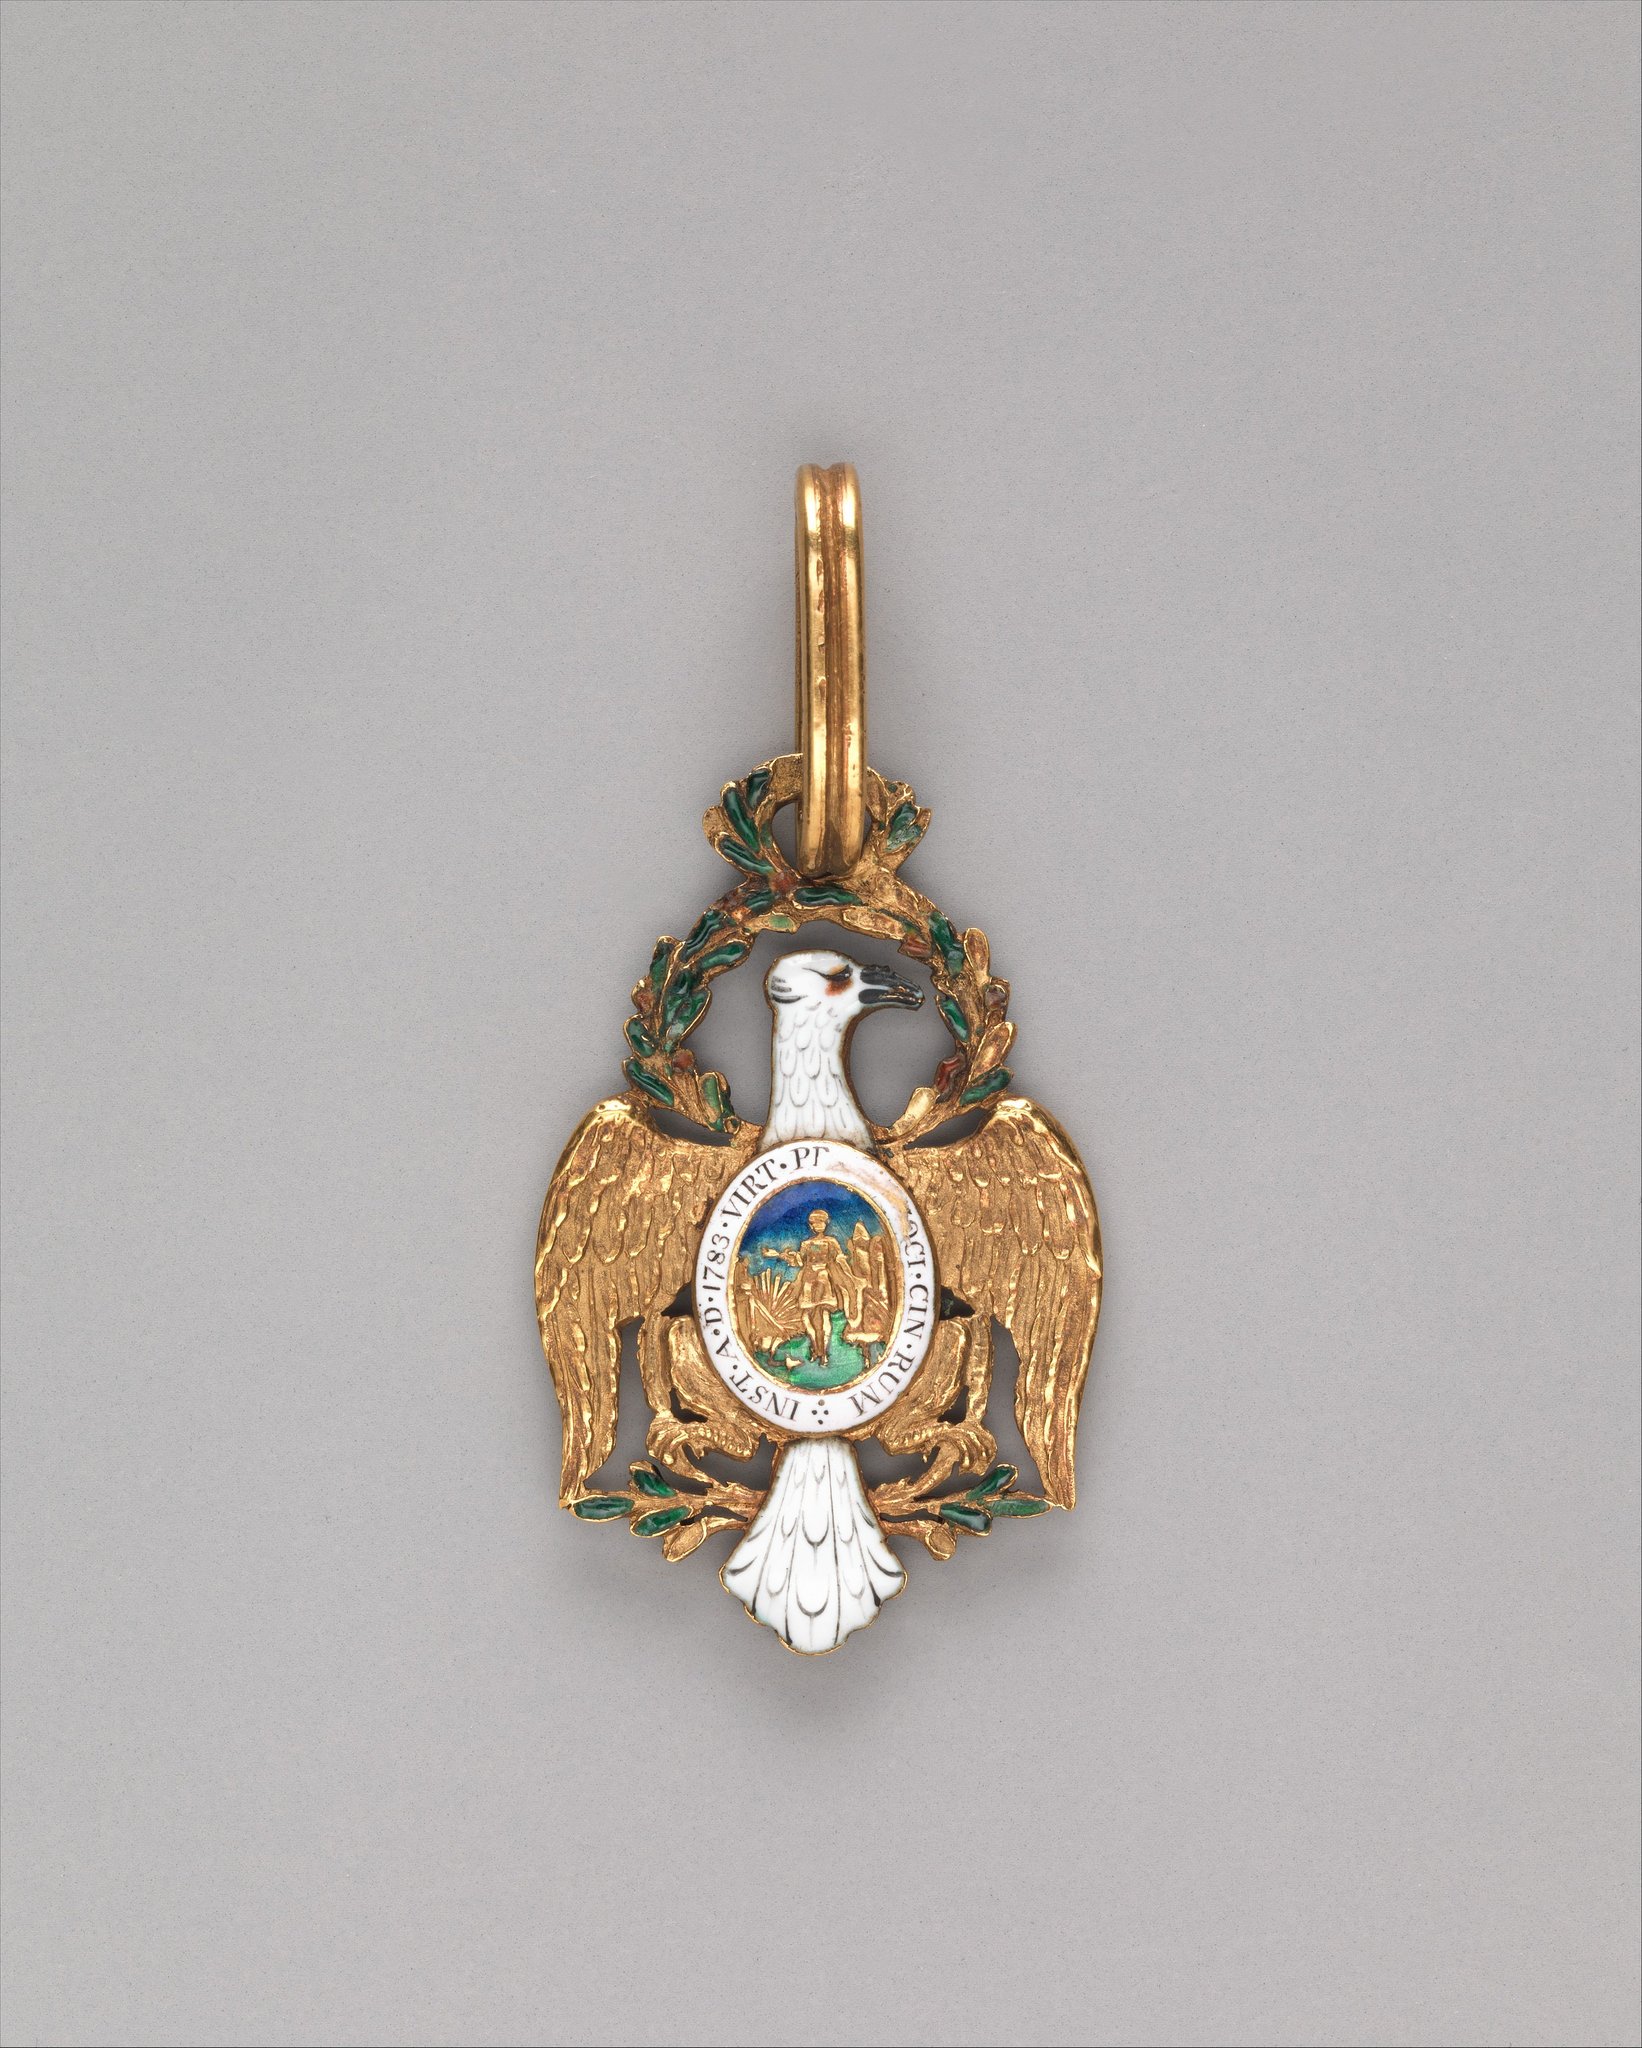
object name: badge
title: Badge of the Cincinnati Medal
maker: pierre charles l'enfant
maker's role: designer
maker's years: 1754-1825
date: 1783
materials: gold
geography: france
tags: eagles